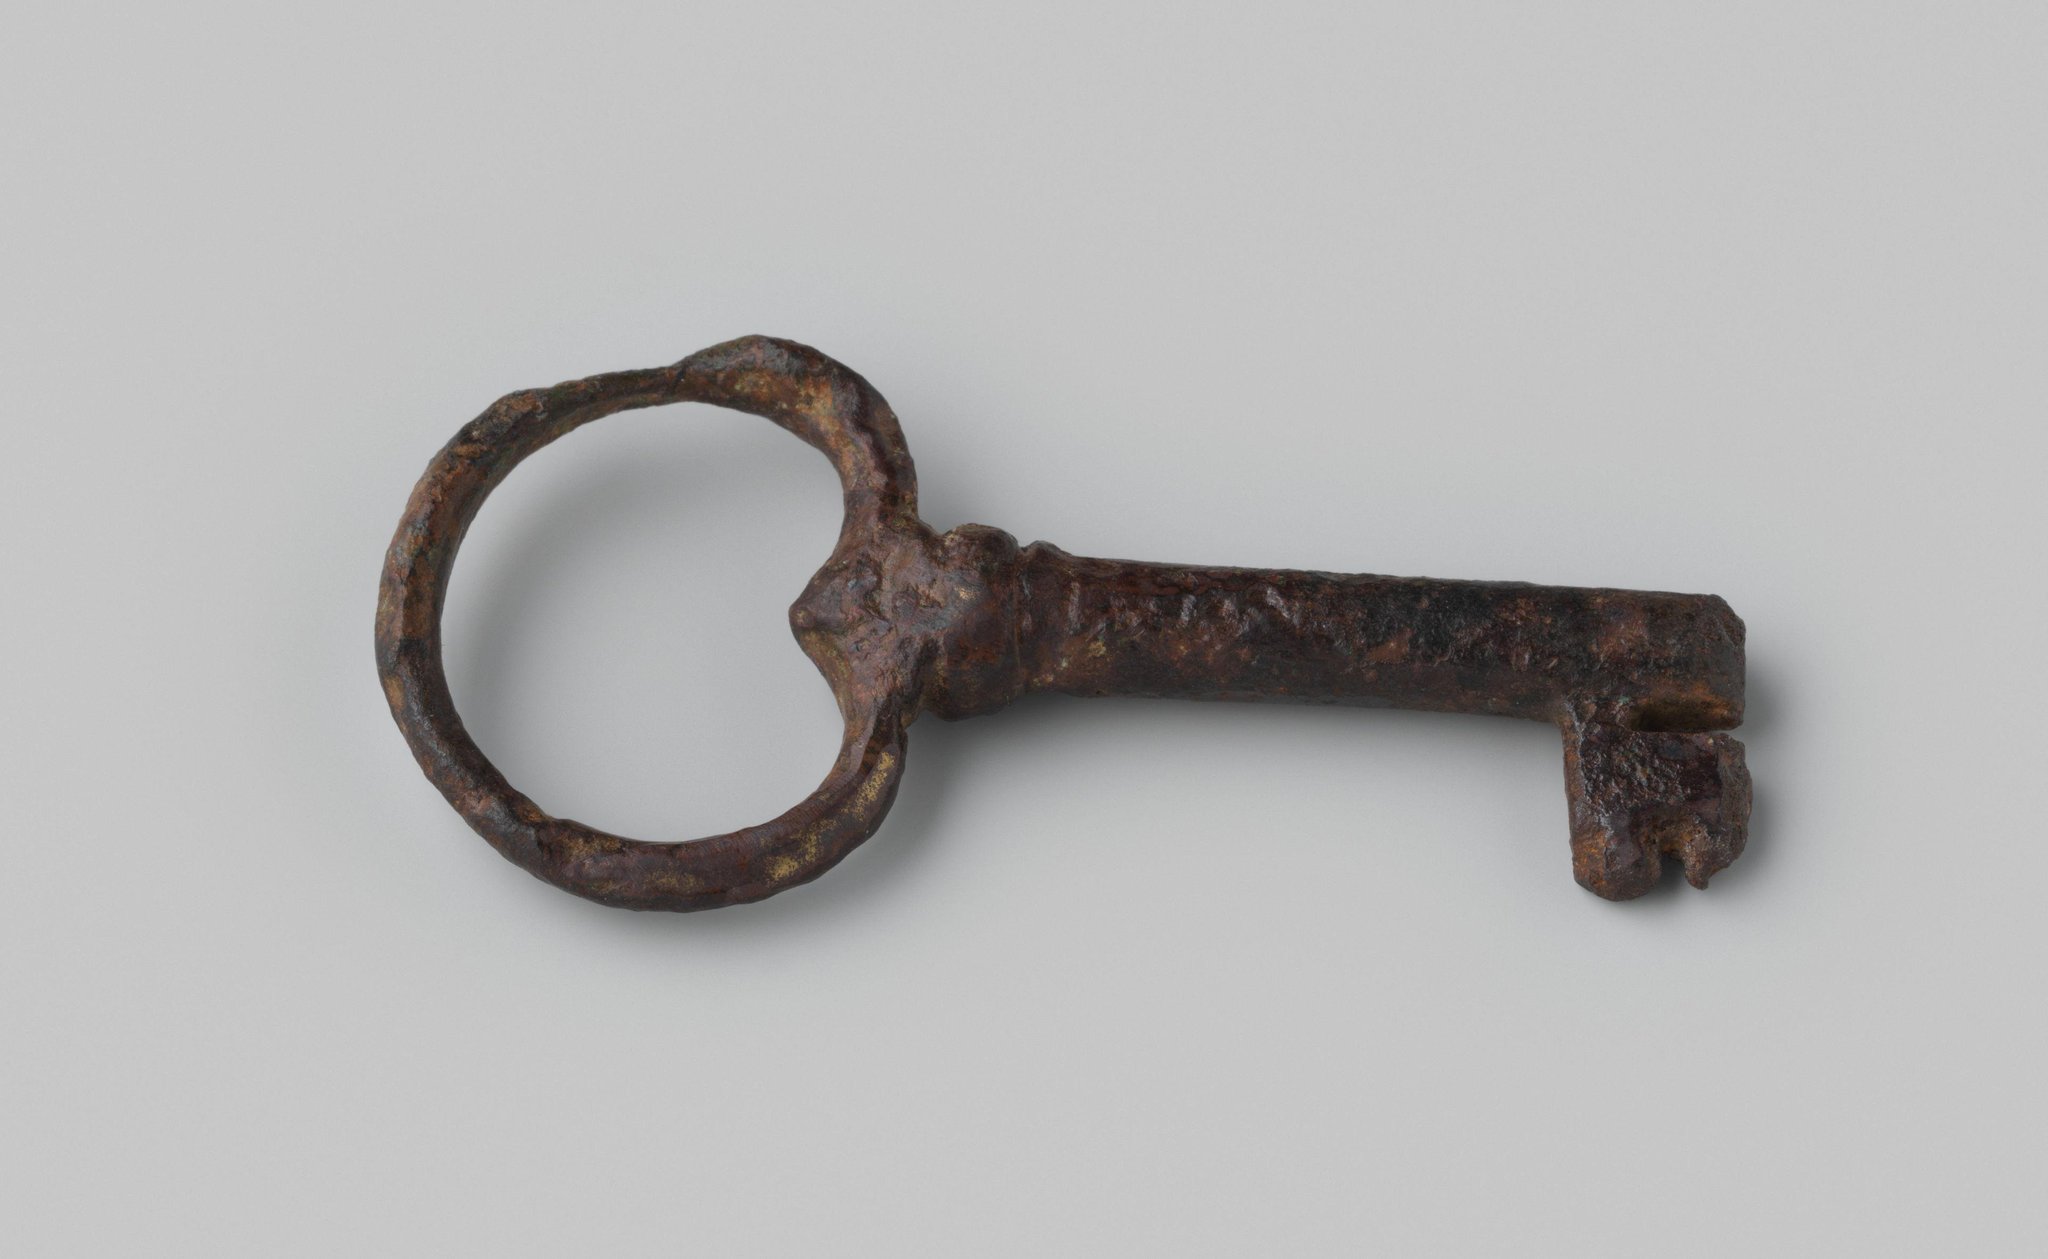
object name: key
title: Sleutel uit het wrak van de Oost-Indiëvaarder Hollandia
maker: Anonymous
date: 1700-1743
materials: copper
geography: netherlands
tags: verenigde oostindische compagnie, hollandia (schip), annet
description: Locks, fastenings and accessories, key; straight, solid shank, circular bow with heart-shaped inner outline, double-notched bit.